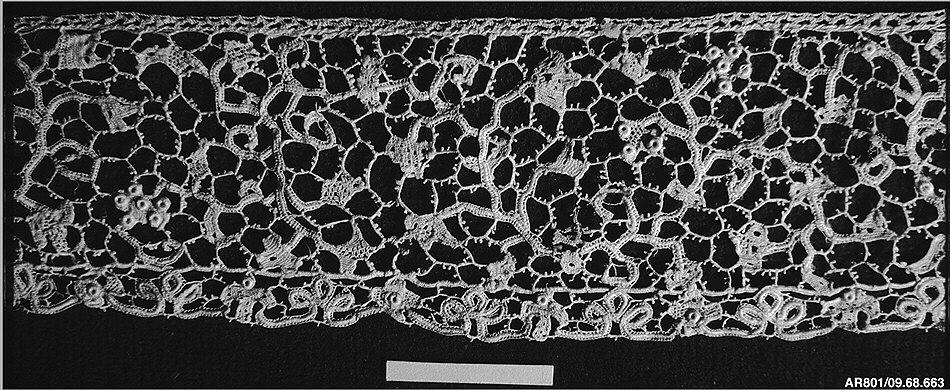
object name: piece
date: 1600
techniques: lace